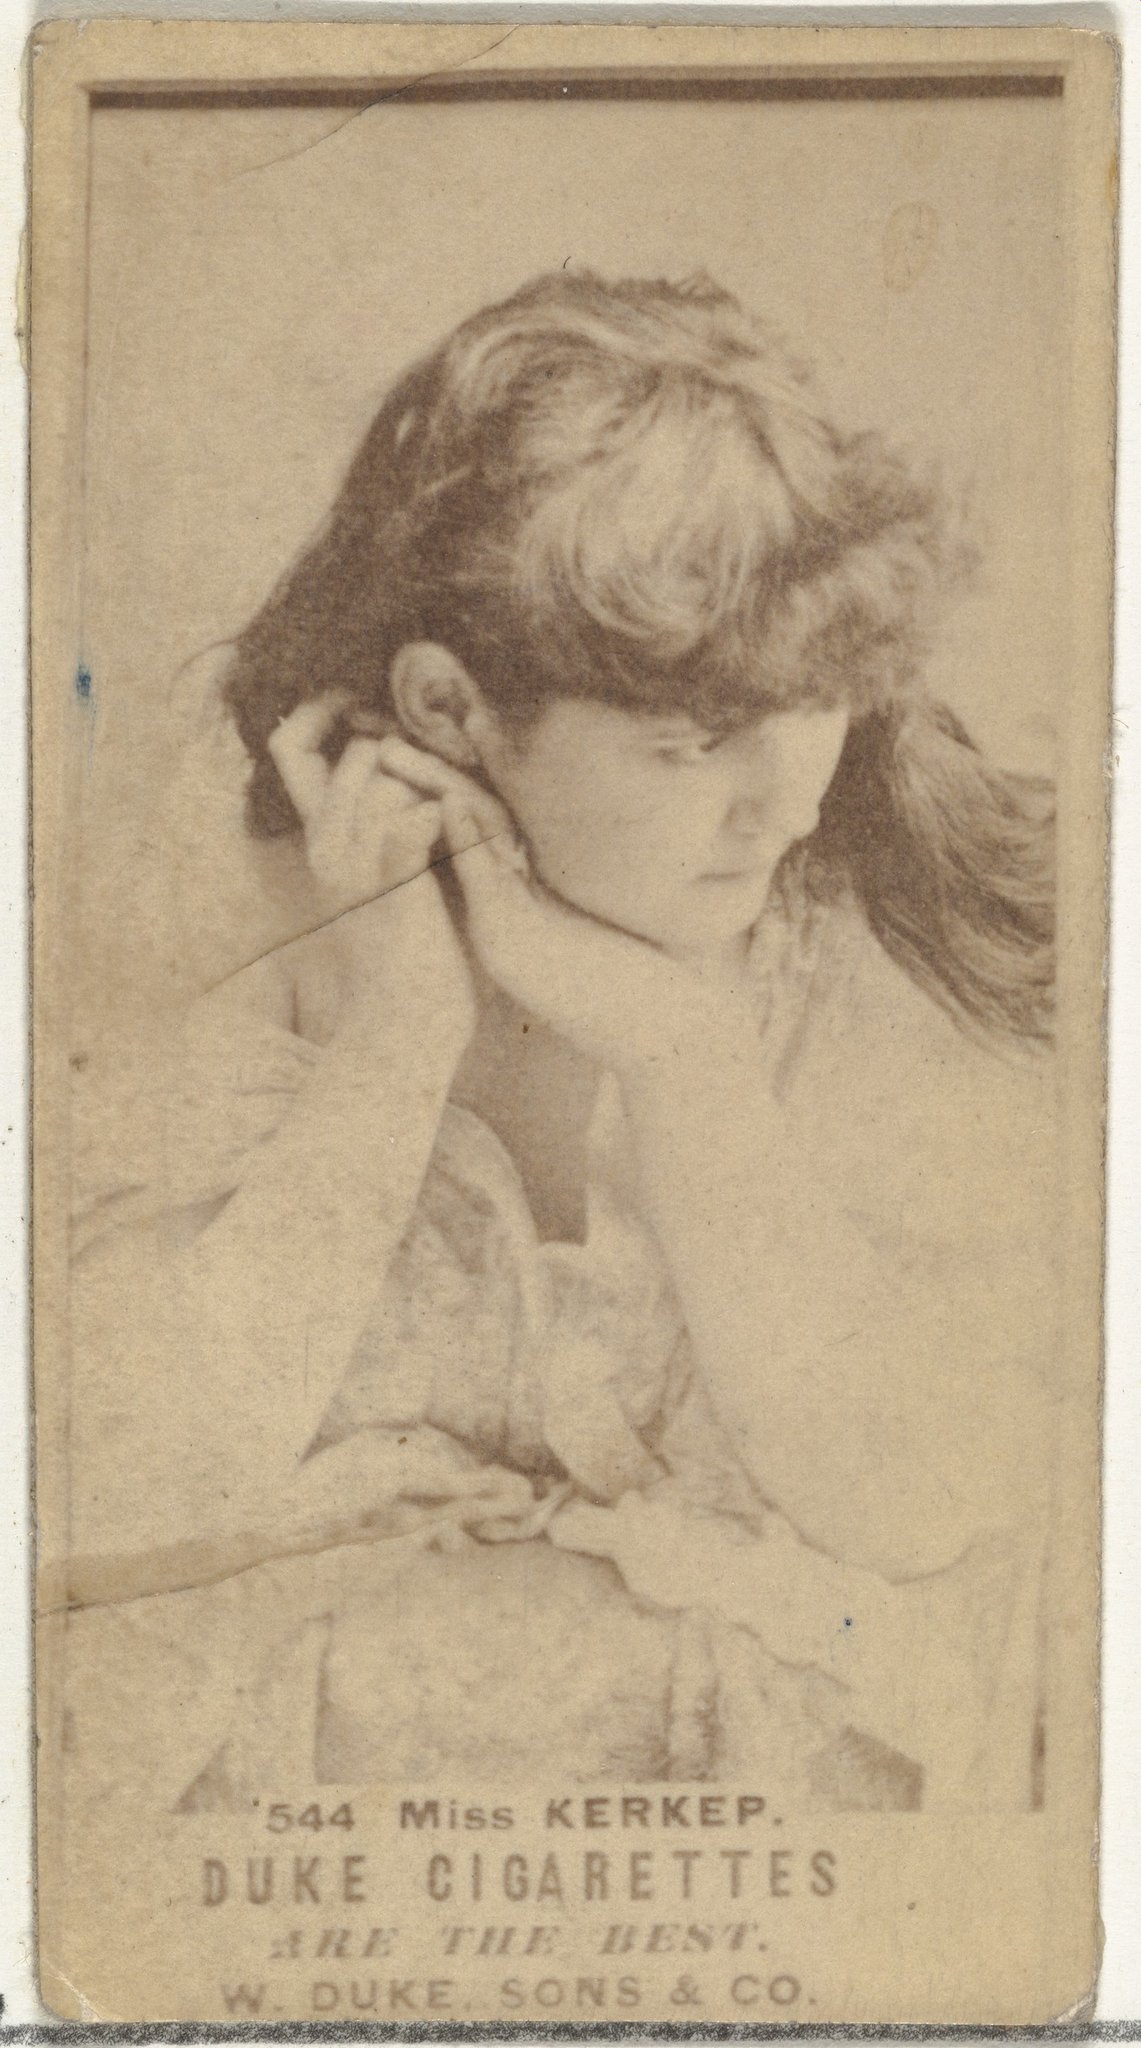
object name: photograph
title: Card Number 544, Miss Kerkep, from the Actors and Actresses series (N145-7) issued by Duke Sons & Co. to promote Duke Cigarettes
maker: w. duke, sons & co.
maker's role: publisher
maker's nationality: american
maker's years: 1870-1920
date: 1880-1889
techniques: albumen silver print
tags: portraits,women,actresses